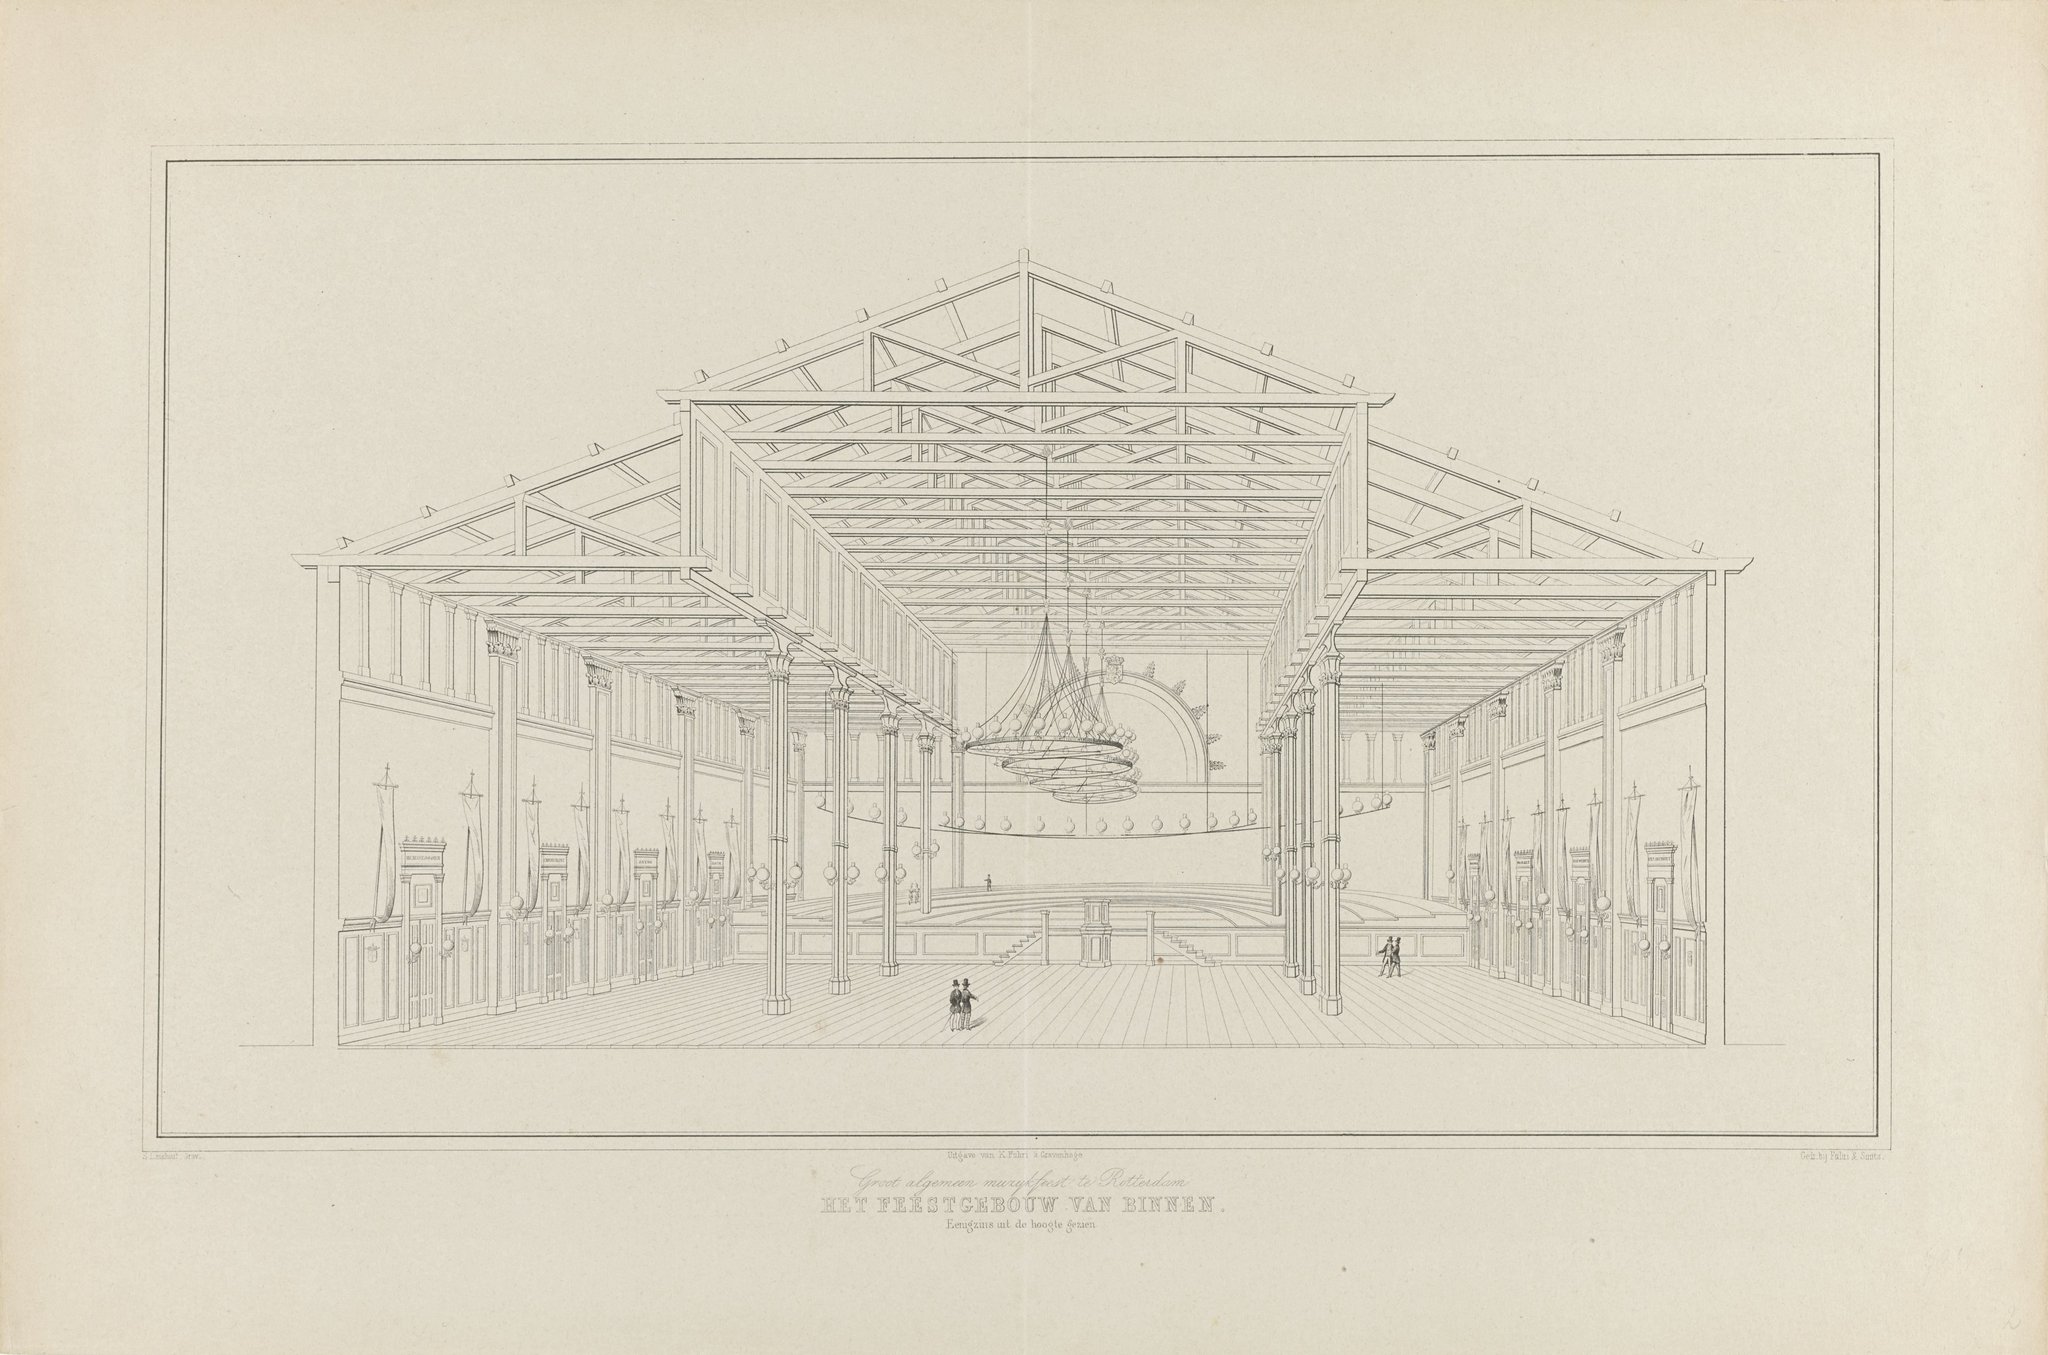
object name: print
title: Groot algemeen muzijkfeest te Rotterdam / Het Feestgebouw van binnen. Eenigzins uit de hoogte gezien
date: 1855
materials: paper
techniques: lithograph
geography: the hague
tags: interior ~ architectural design or model, concert hall, rotterdam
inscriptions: collector's mark: Lugt 2228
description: Gezicht in het interieur van het nieuwe Feestgebouw waar het muziekfeest is gehouden, 1854. Onderdeel van een serie van twaalf portretten naar daguerrotypieën en twaalf stadsgezichten. Ter gelegenheid van het Muziekfeest ter viering van het 25-jarige bestaan van de Maatschappij ter Bevordering van Toonkunst in Rotterdam, 12-15 juli 1854.